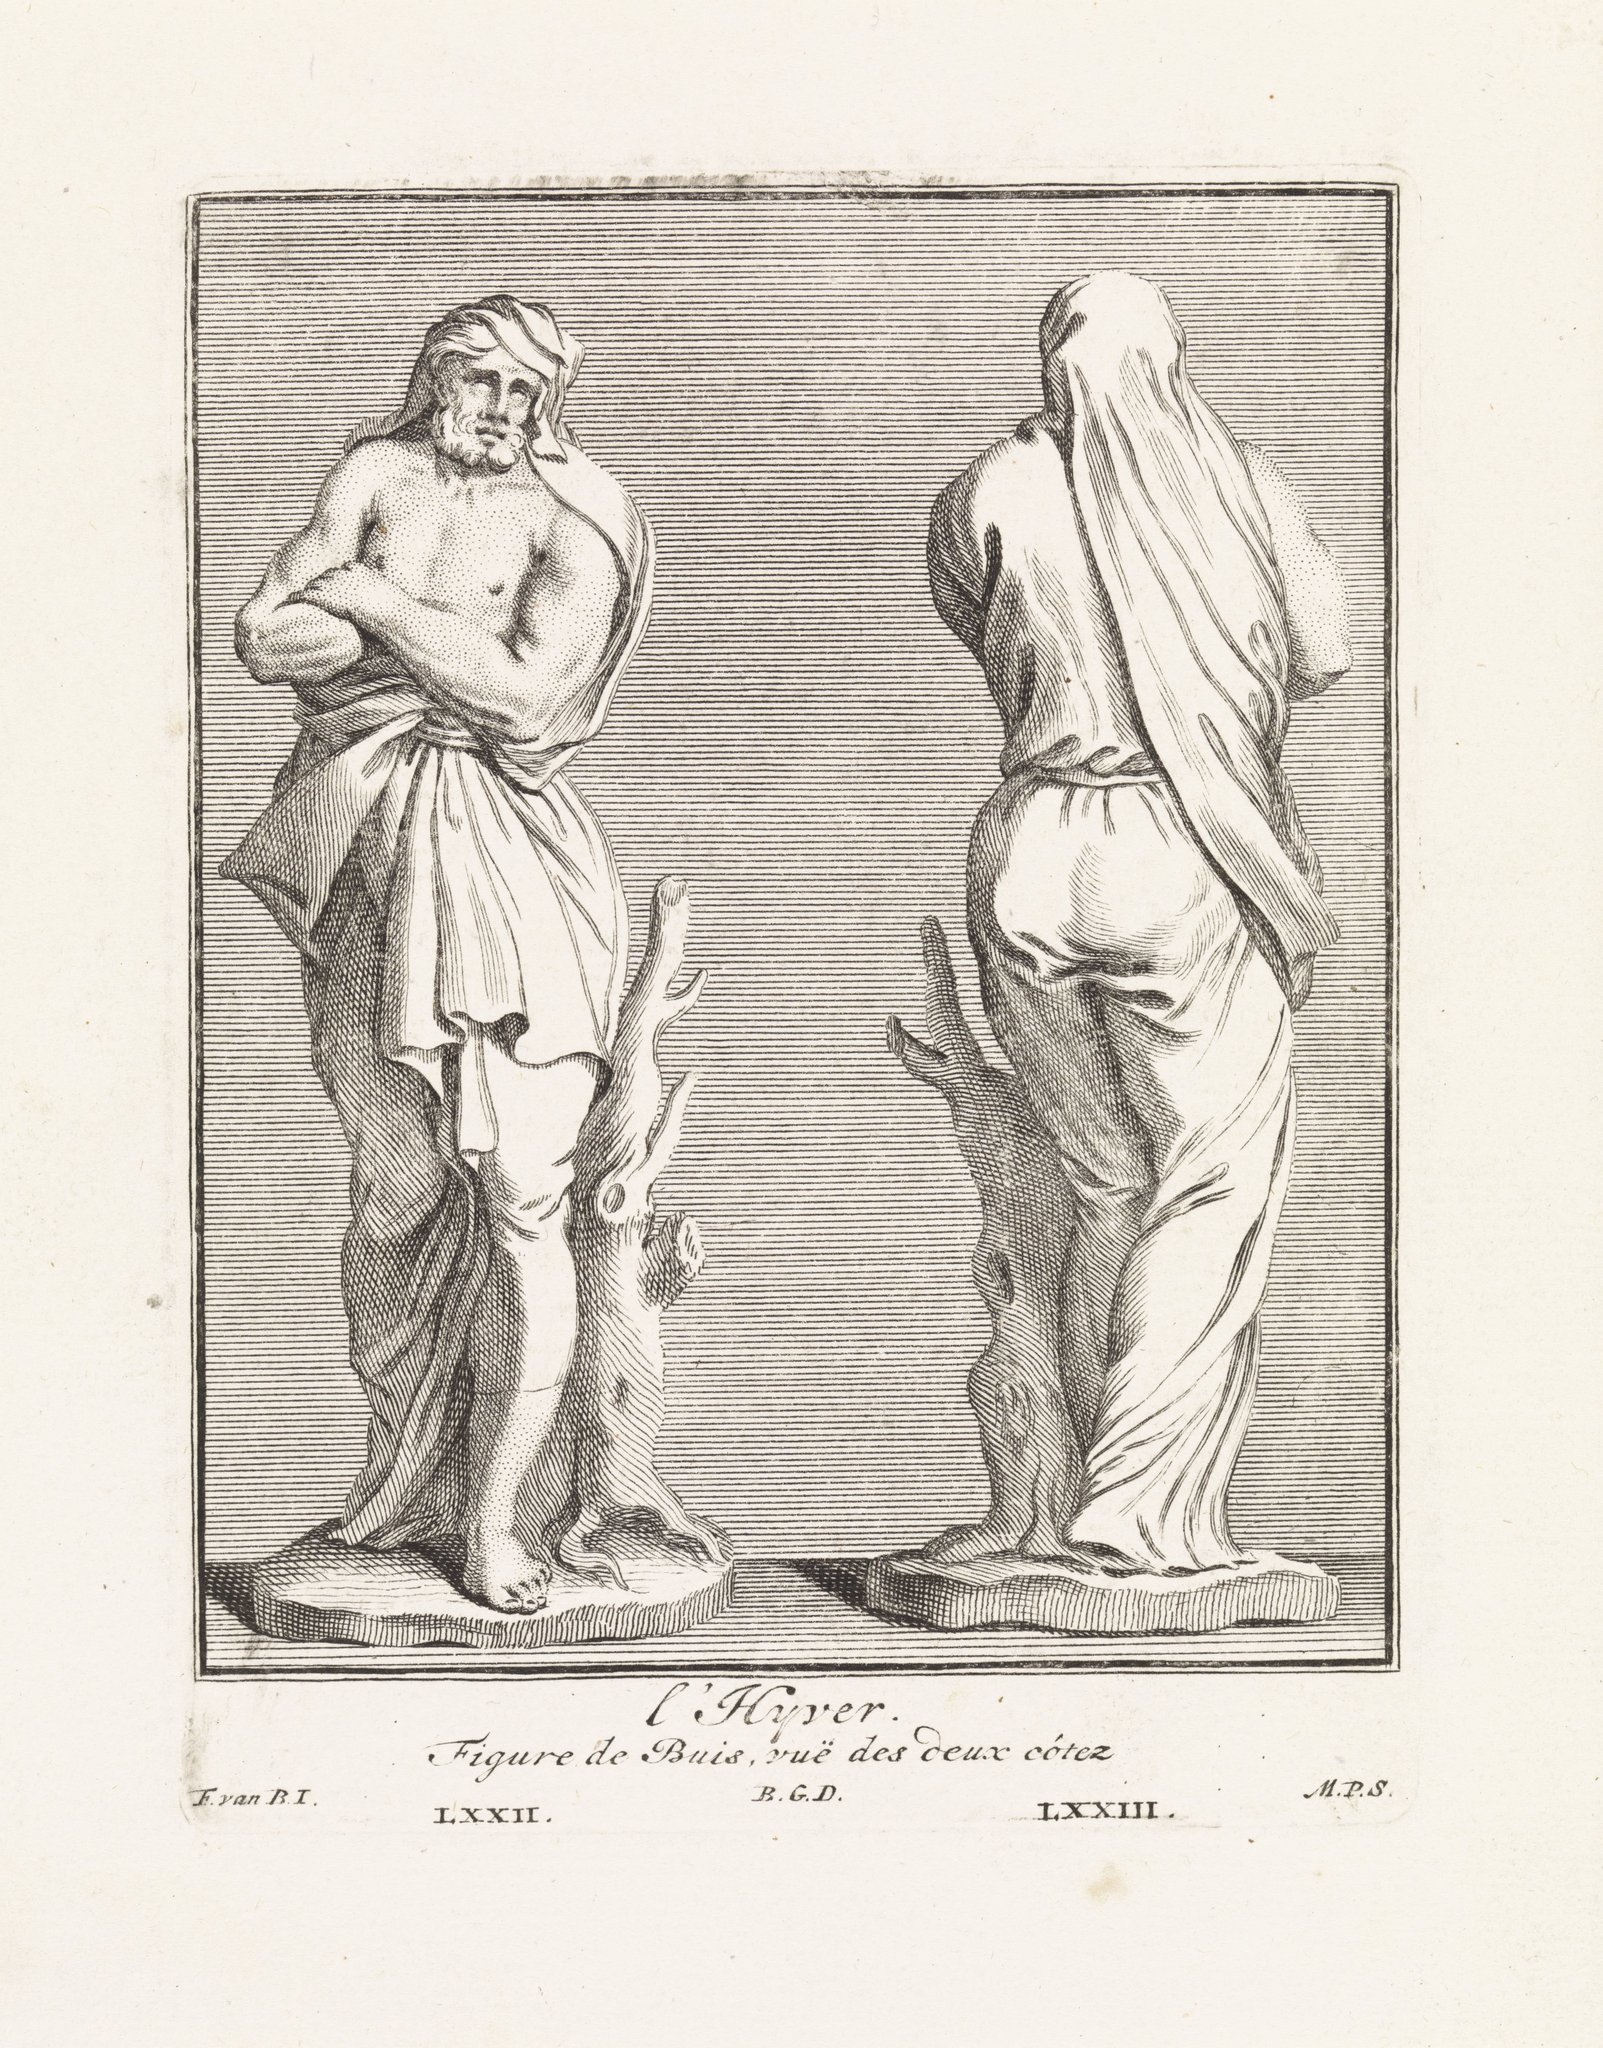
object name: print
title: Standbeeld van de Winter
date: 1727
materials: paper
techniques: engraving, etching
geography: amsterdam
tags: winter, 'hyems'; 'inverno' (ripa), piece of sculpture, reproduction of a piece of sculpture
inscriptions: collector's mark: Lugt 2228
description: Prent ook gebruikt in: Bossuit, Francis van. Cabinet de l'art de schulpture (...). Executé en yvoire (...). = Beeld-snyders kunst-kabinet (...). = Statues, or Art's cabinet. Amsterdam: M. Pool, 1727.